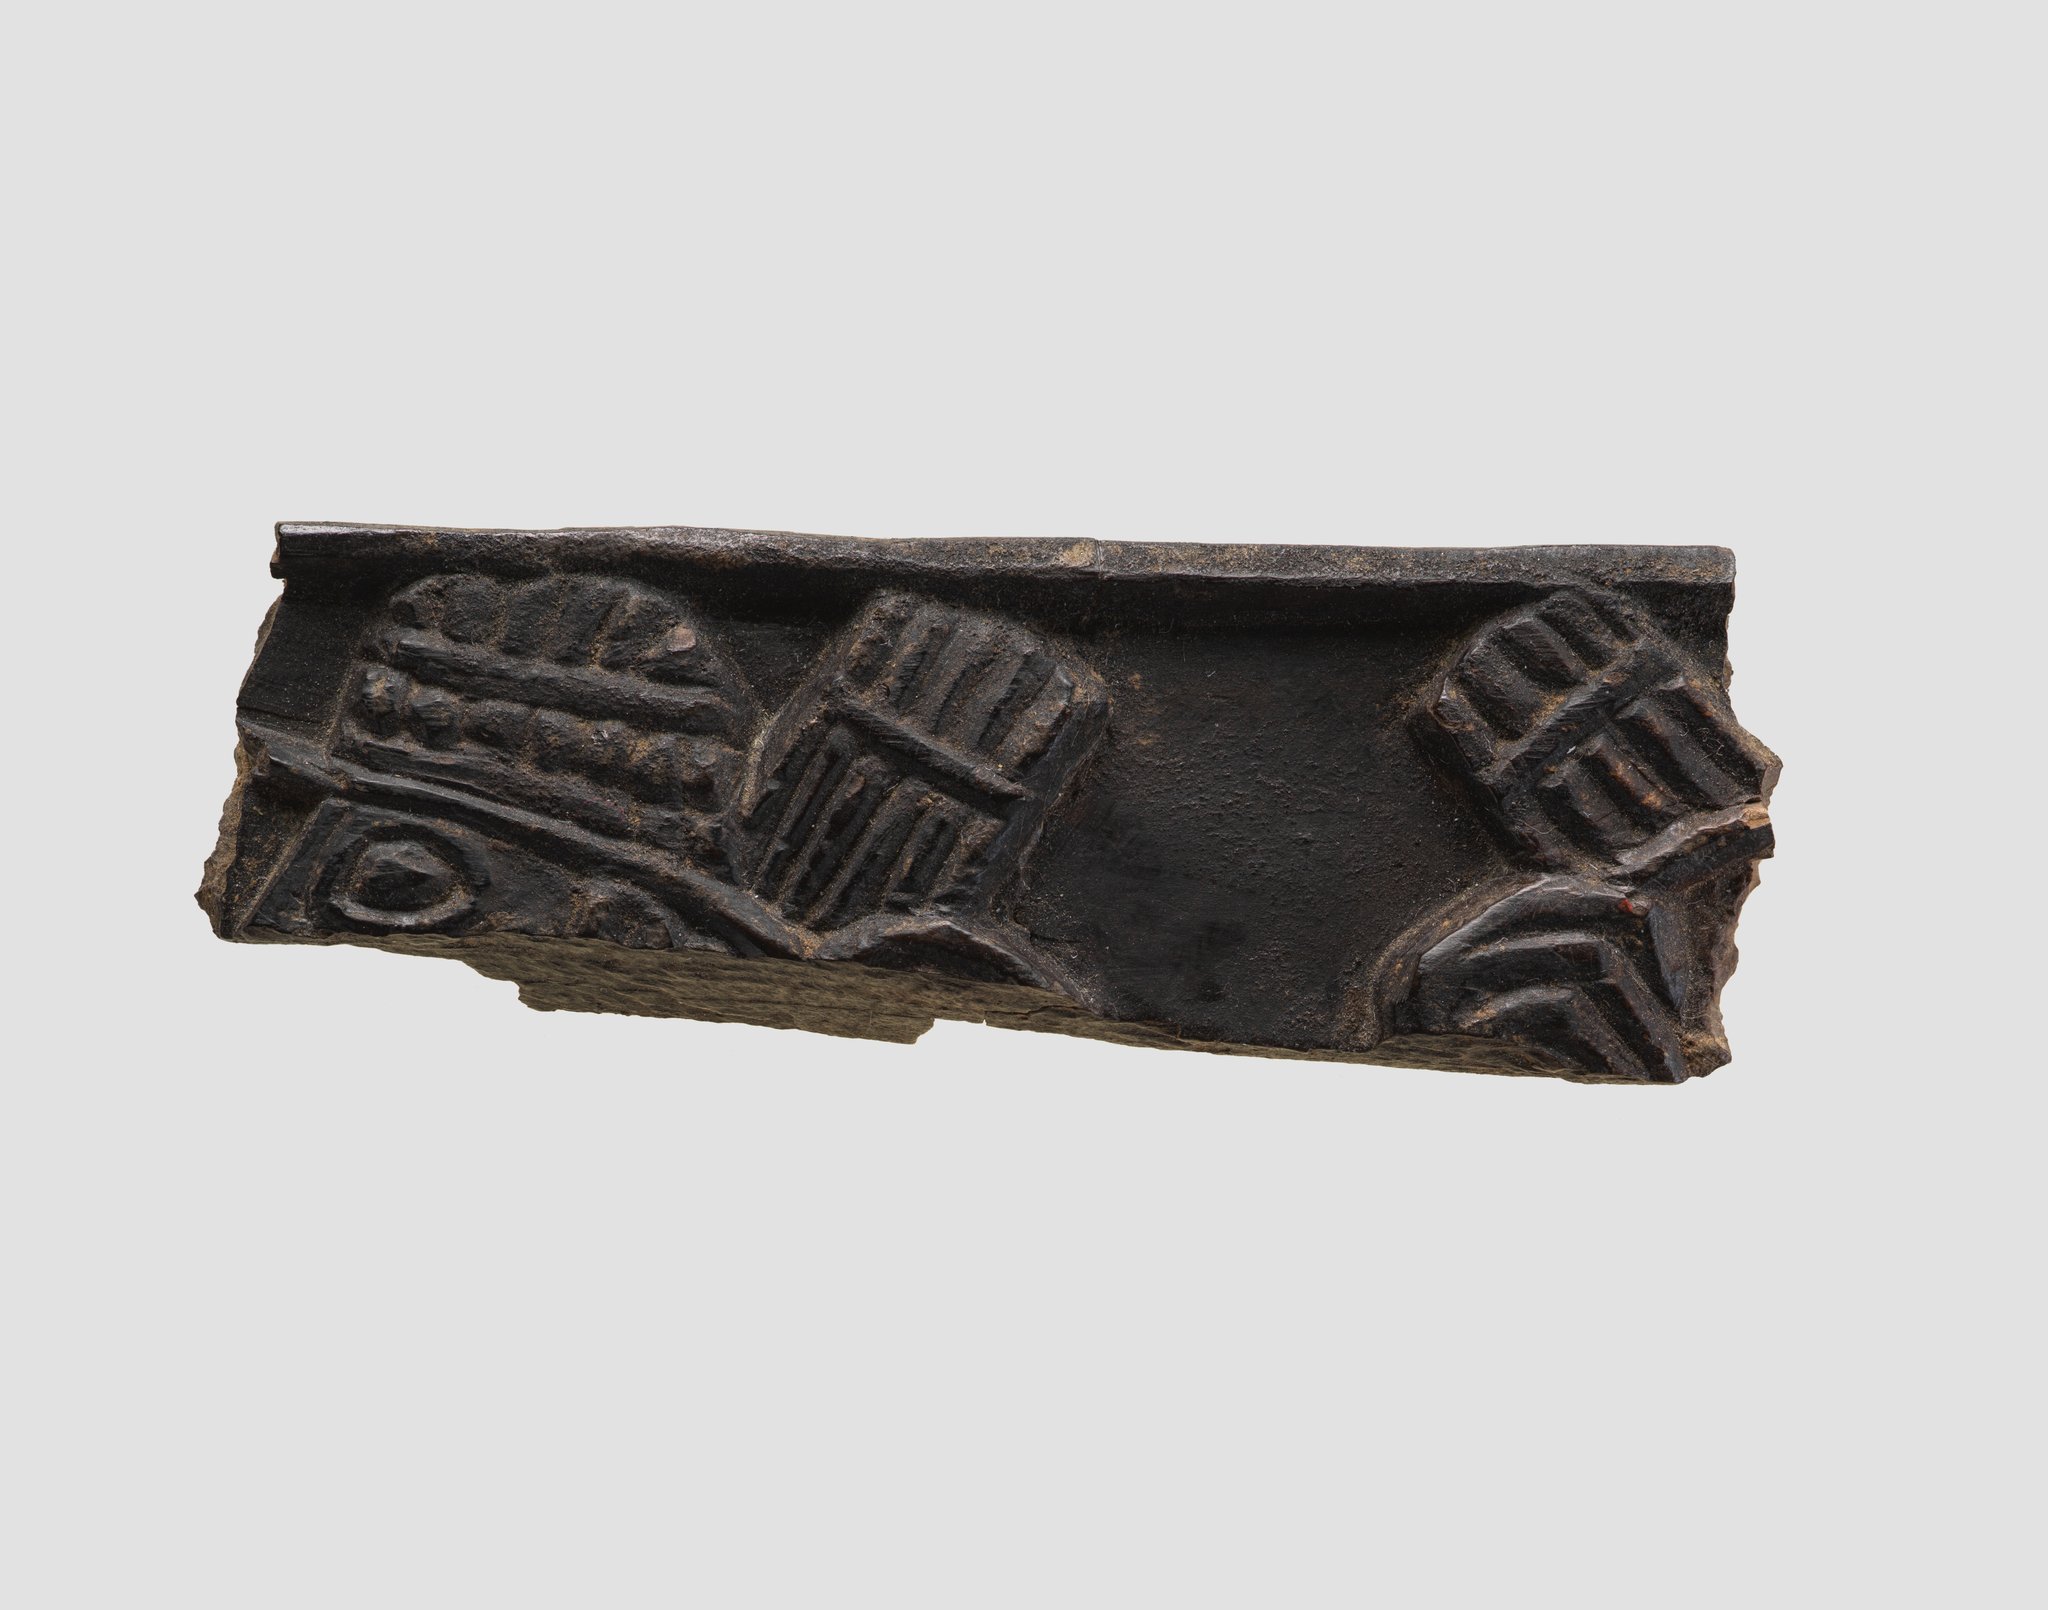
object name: relief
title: Plaque fragment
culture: iranian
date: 900-801 BCE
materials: ivory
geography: iran